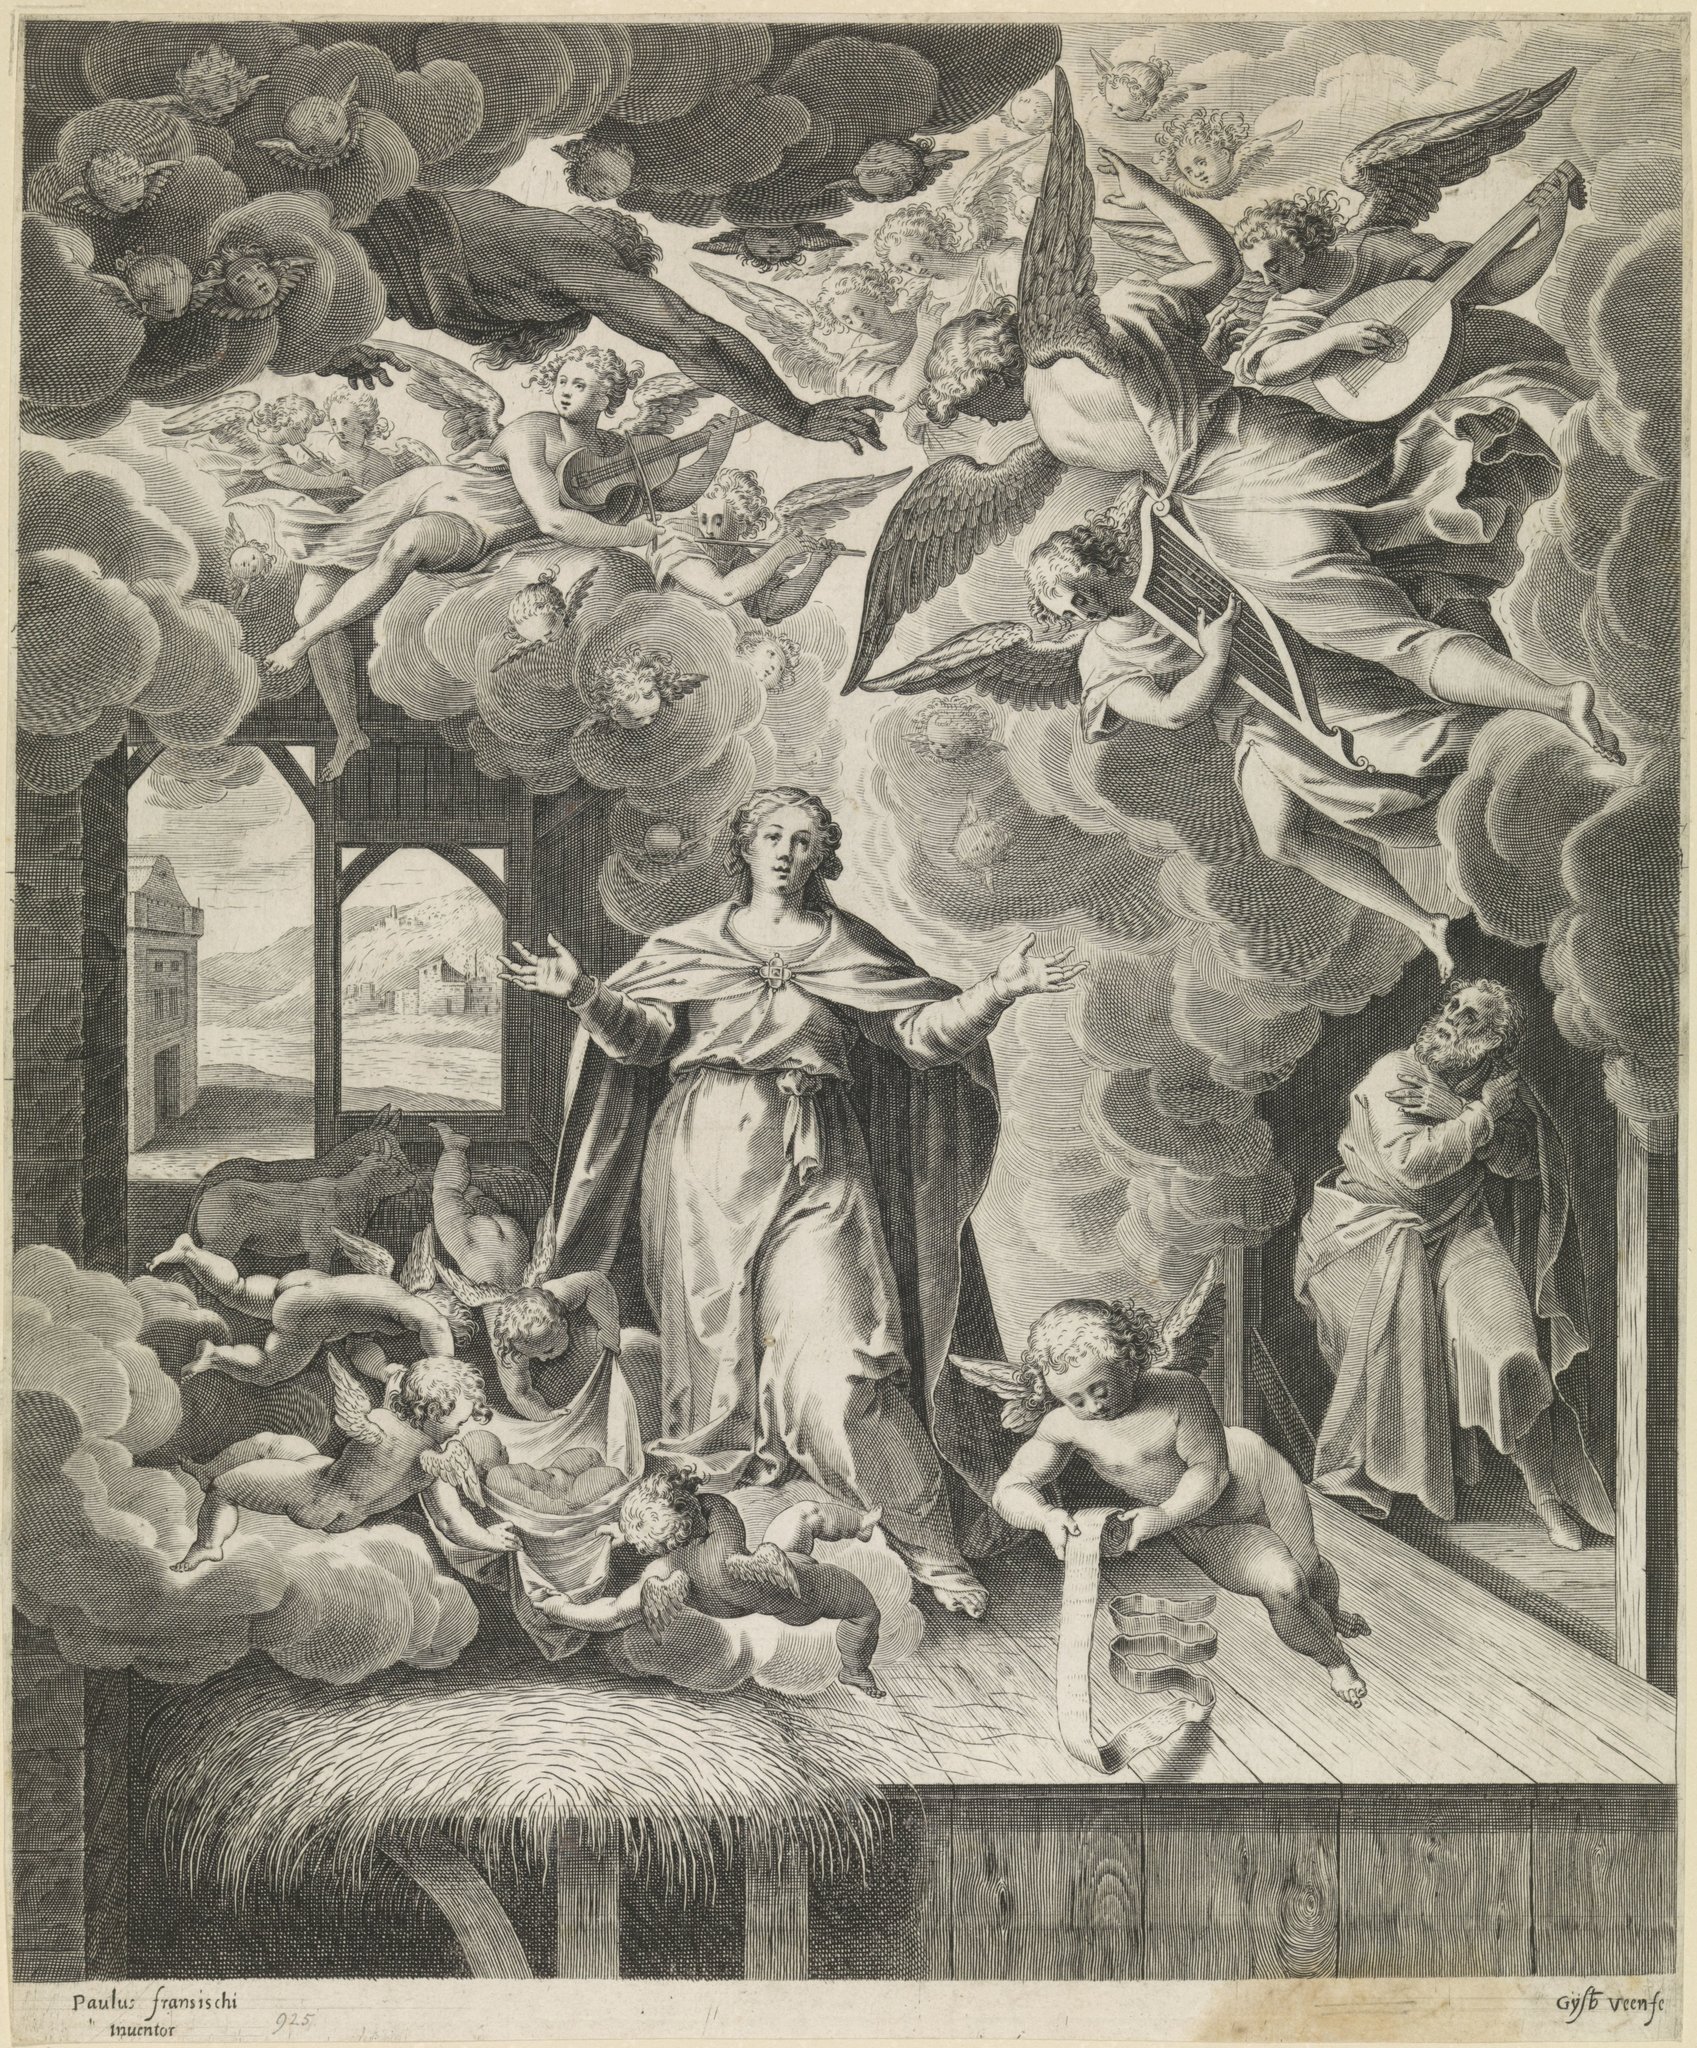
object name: print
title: Geboorte van Christus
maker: pauwels franck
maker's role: draughtsman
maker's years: 1540-1596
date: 1572-1628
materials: paper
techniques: engraving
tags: angels singing, making music, adoration of the christ-child by mary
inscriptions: collector's mark: Lugt 240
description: Maria staat met gespreide armen op de houten vloer van een stal. Engelen voor haar tonen haar het kind dat in een doek ligt. Boven haar hoofd musicerende engelen. Rechts, door een deuropening, Jozef met gekruiste armen voor zijn borst.